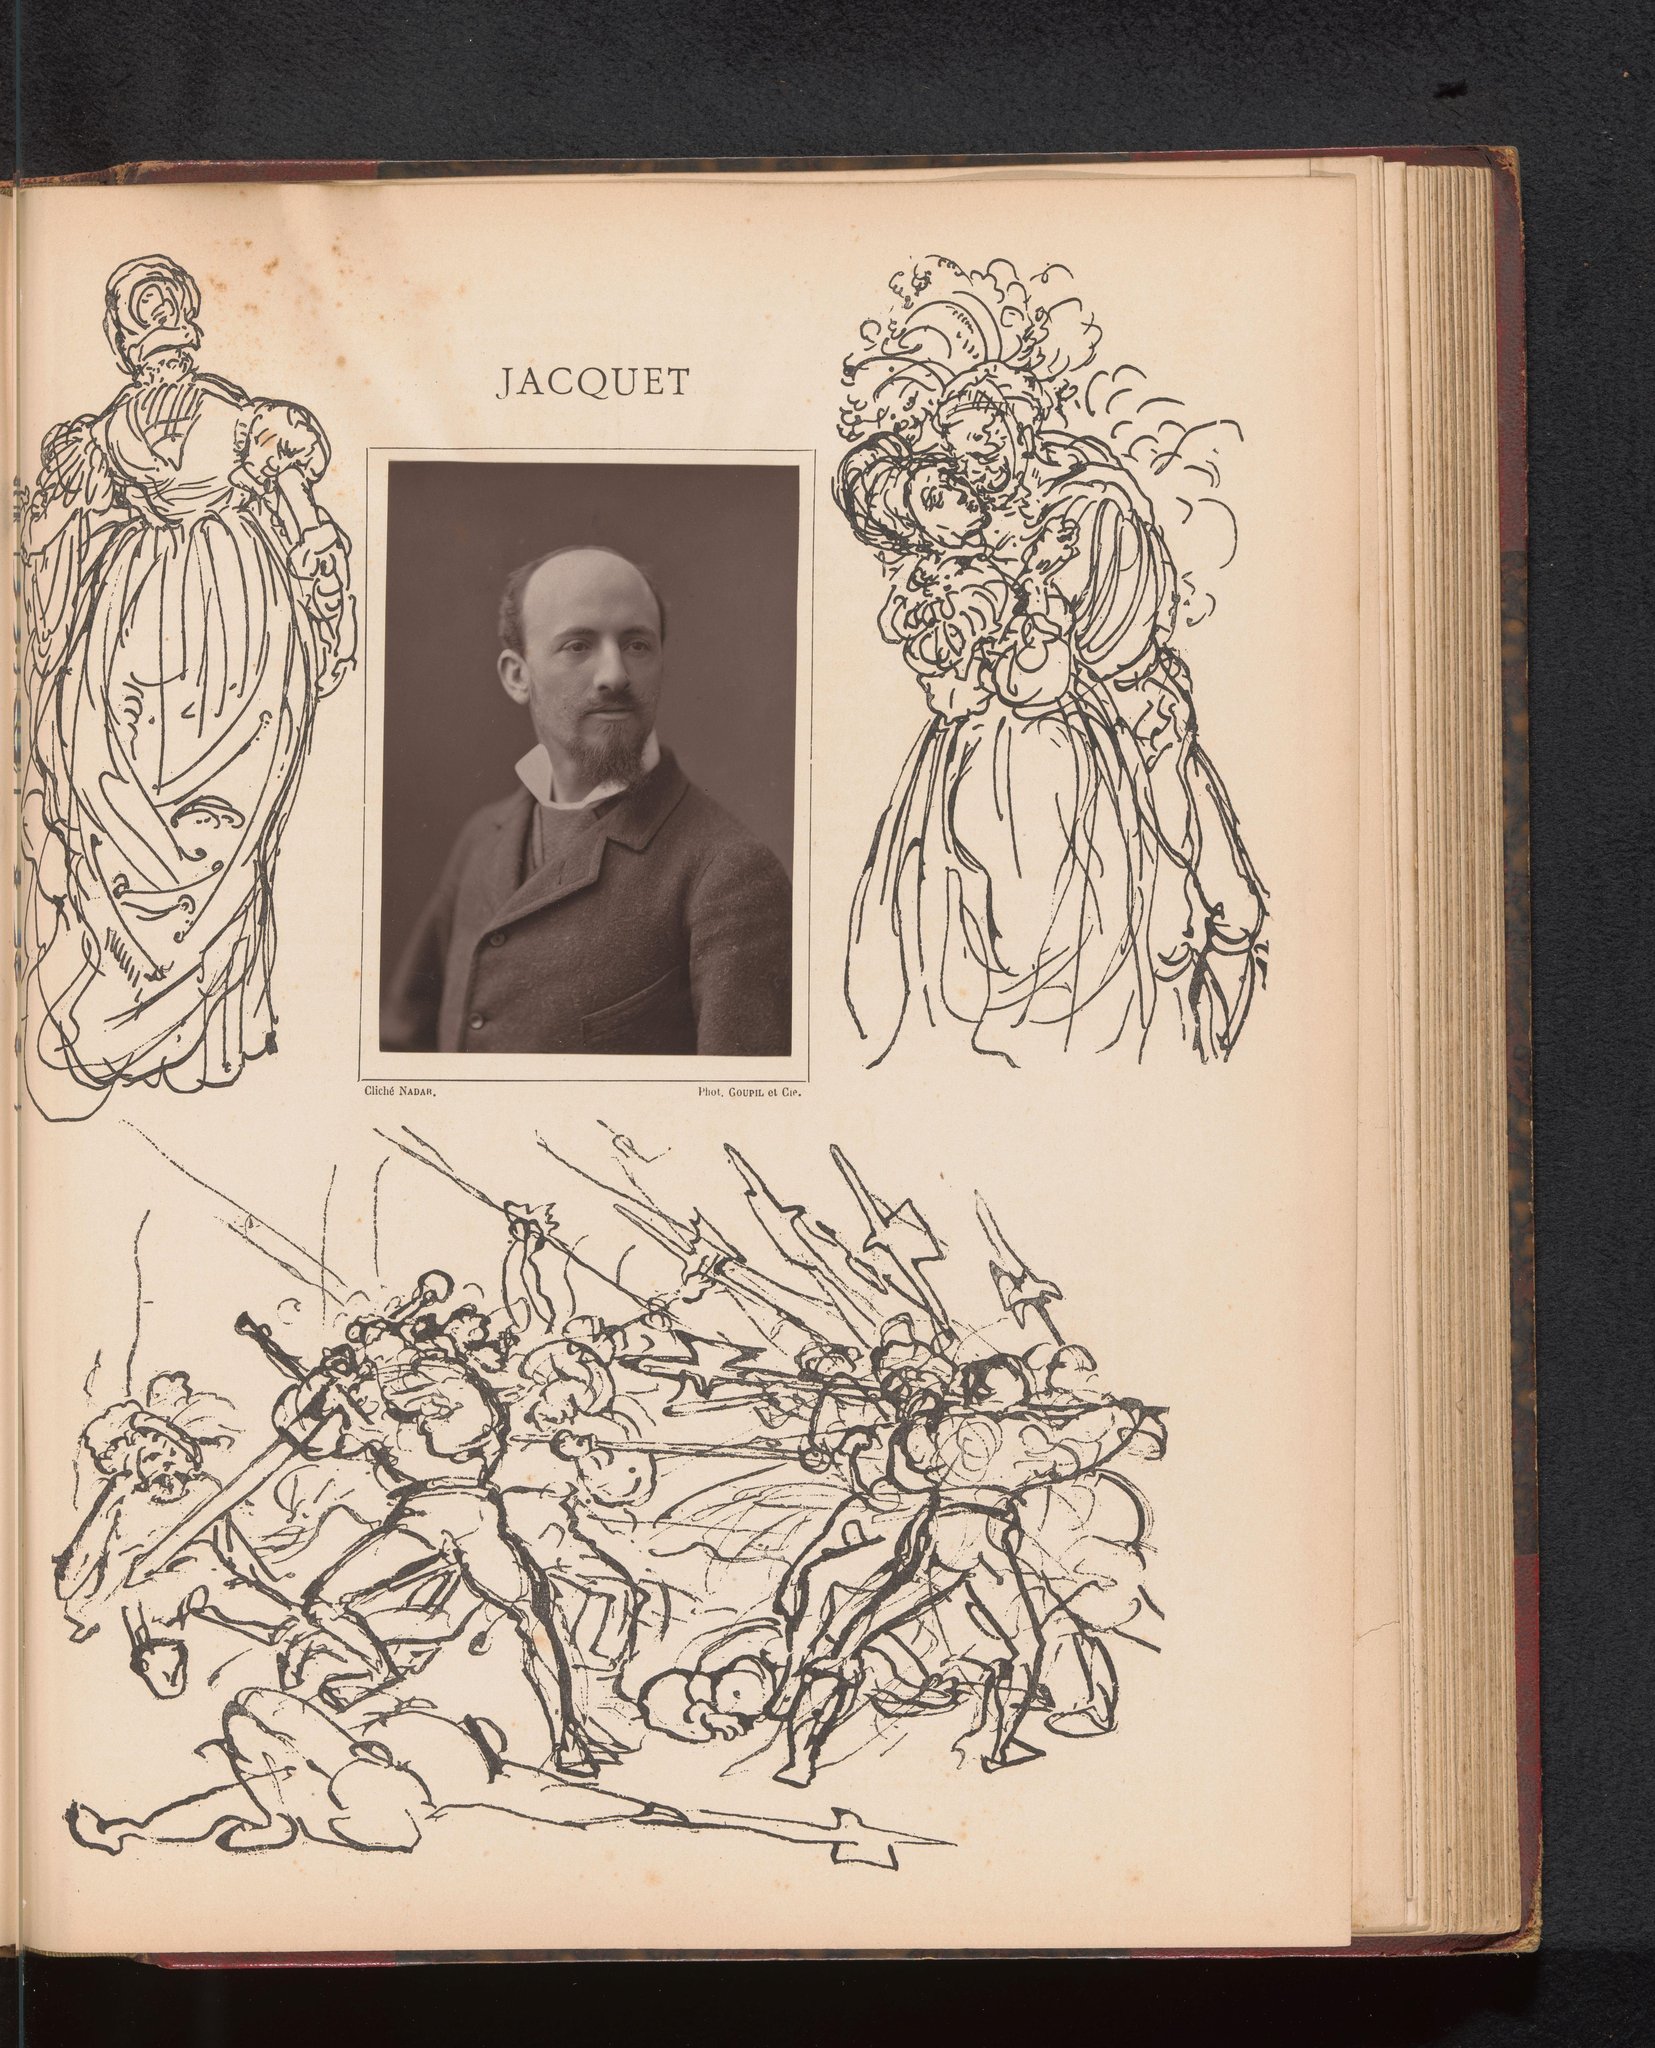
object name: photomechanical print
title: Portret van Gustave Jean Jacquet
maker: félix nadar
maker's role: ballonvaarder, fotograaf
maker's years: 1820-1910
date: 1873-1878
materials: paper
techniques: woodburytype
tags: paris, painter, gustave jean jacquet, historical persons, portrait, self-portrait of painter